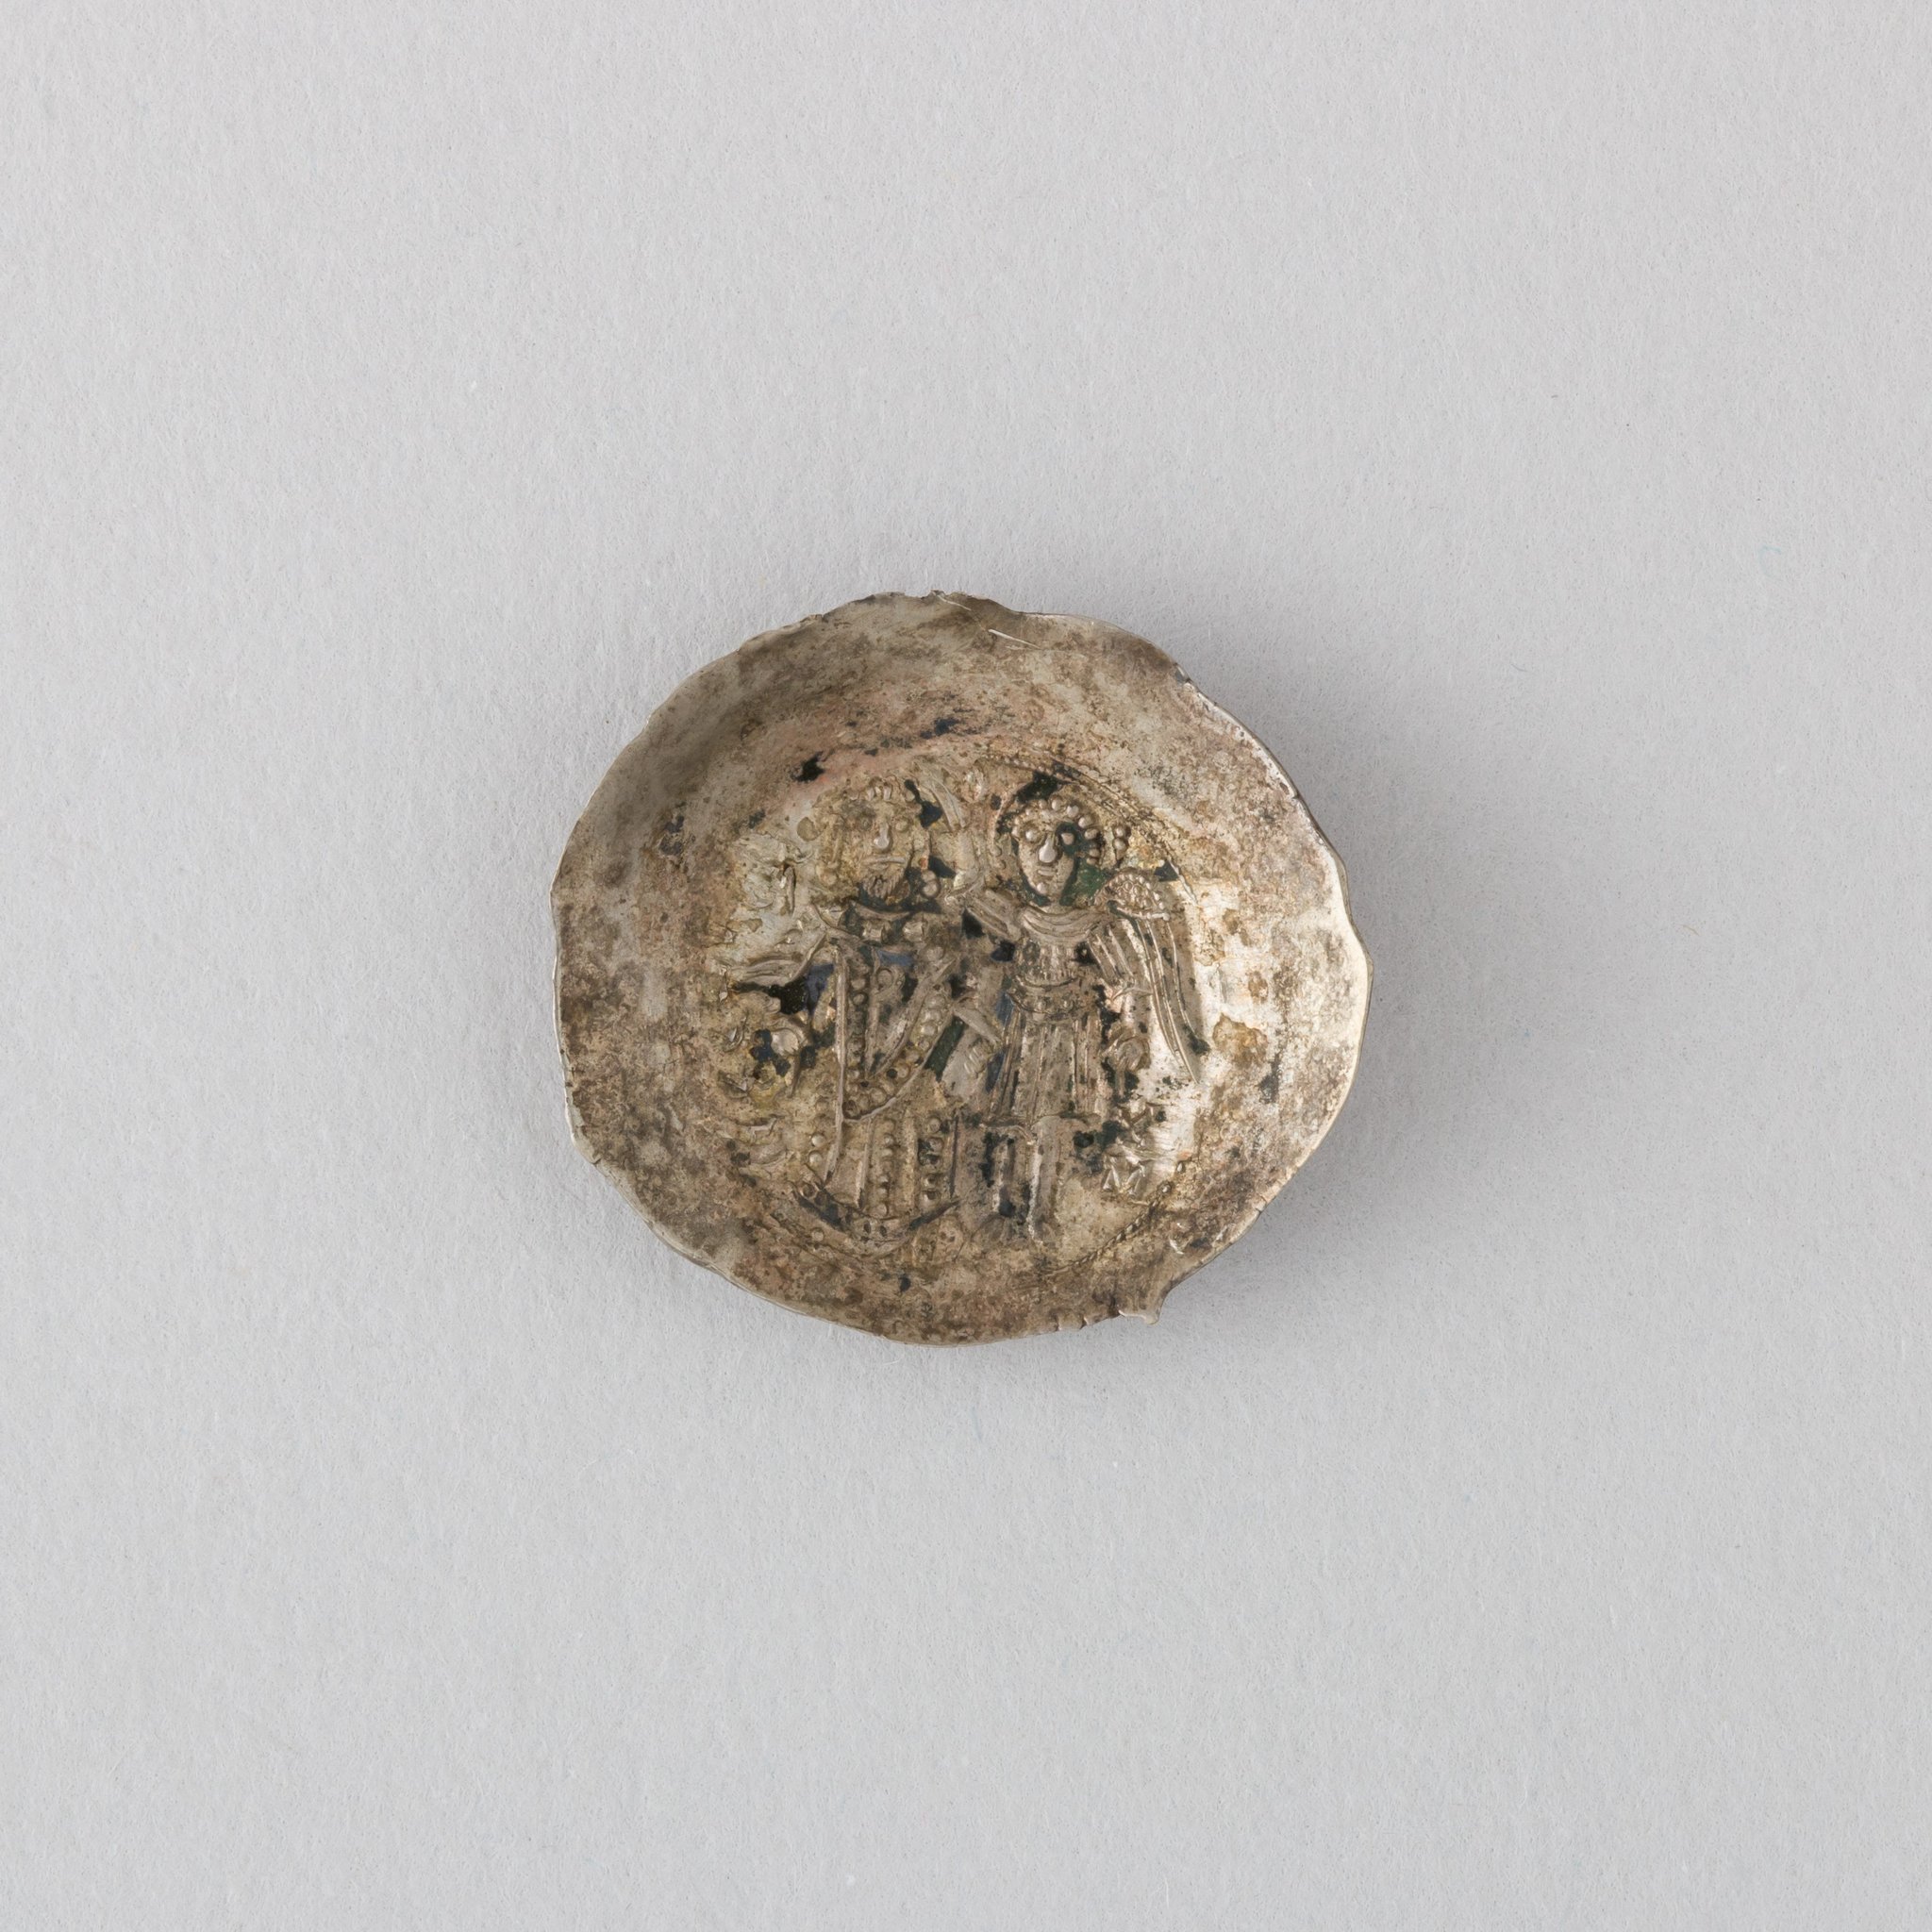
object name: coin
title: Coin Nomisma Isaac II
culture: byzantine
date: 1101-1200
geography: byzantium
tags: coins